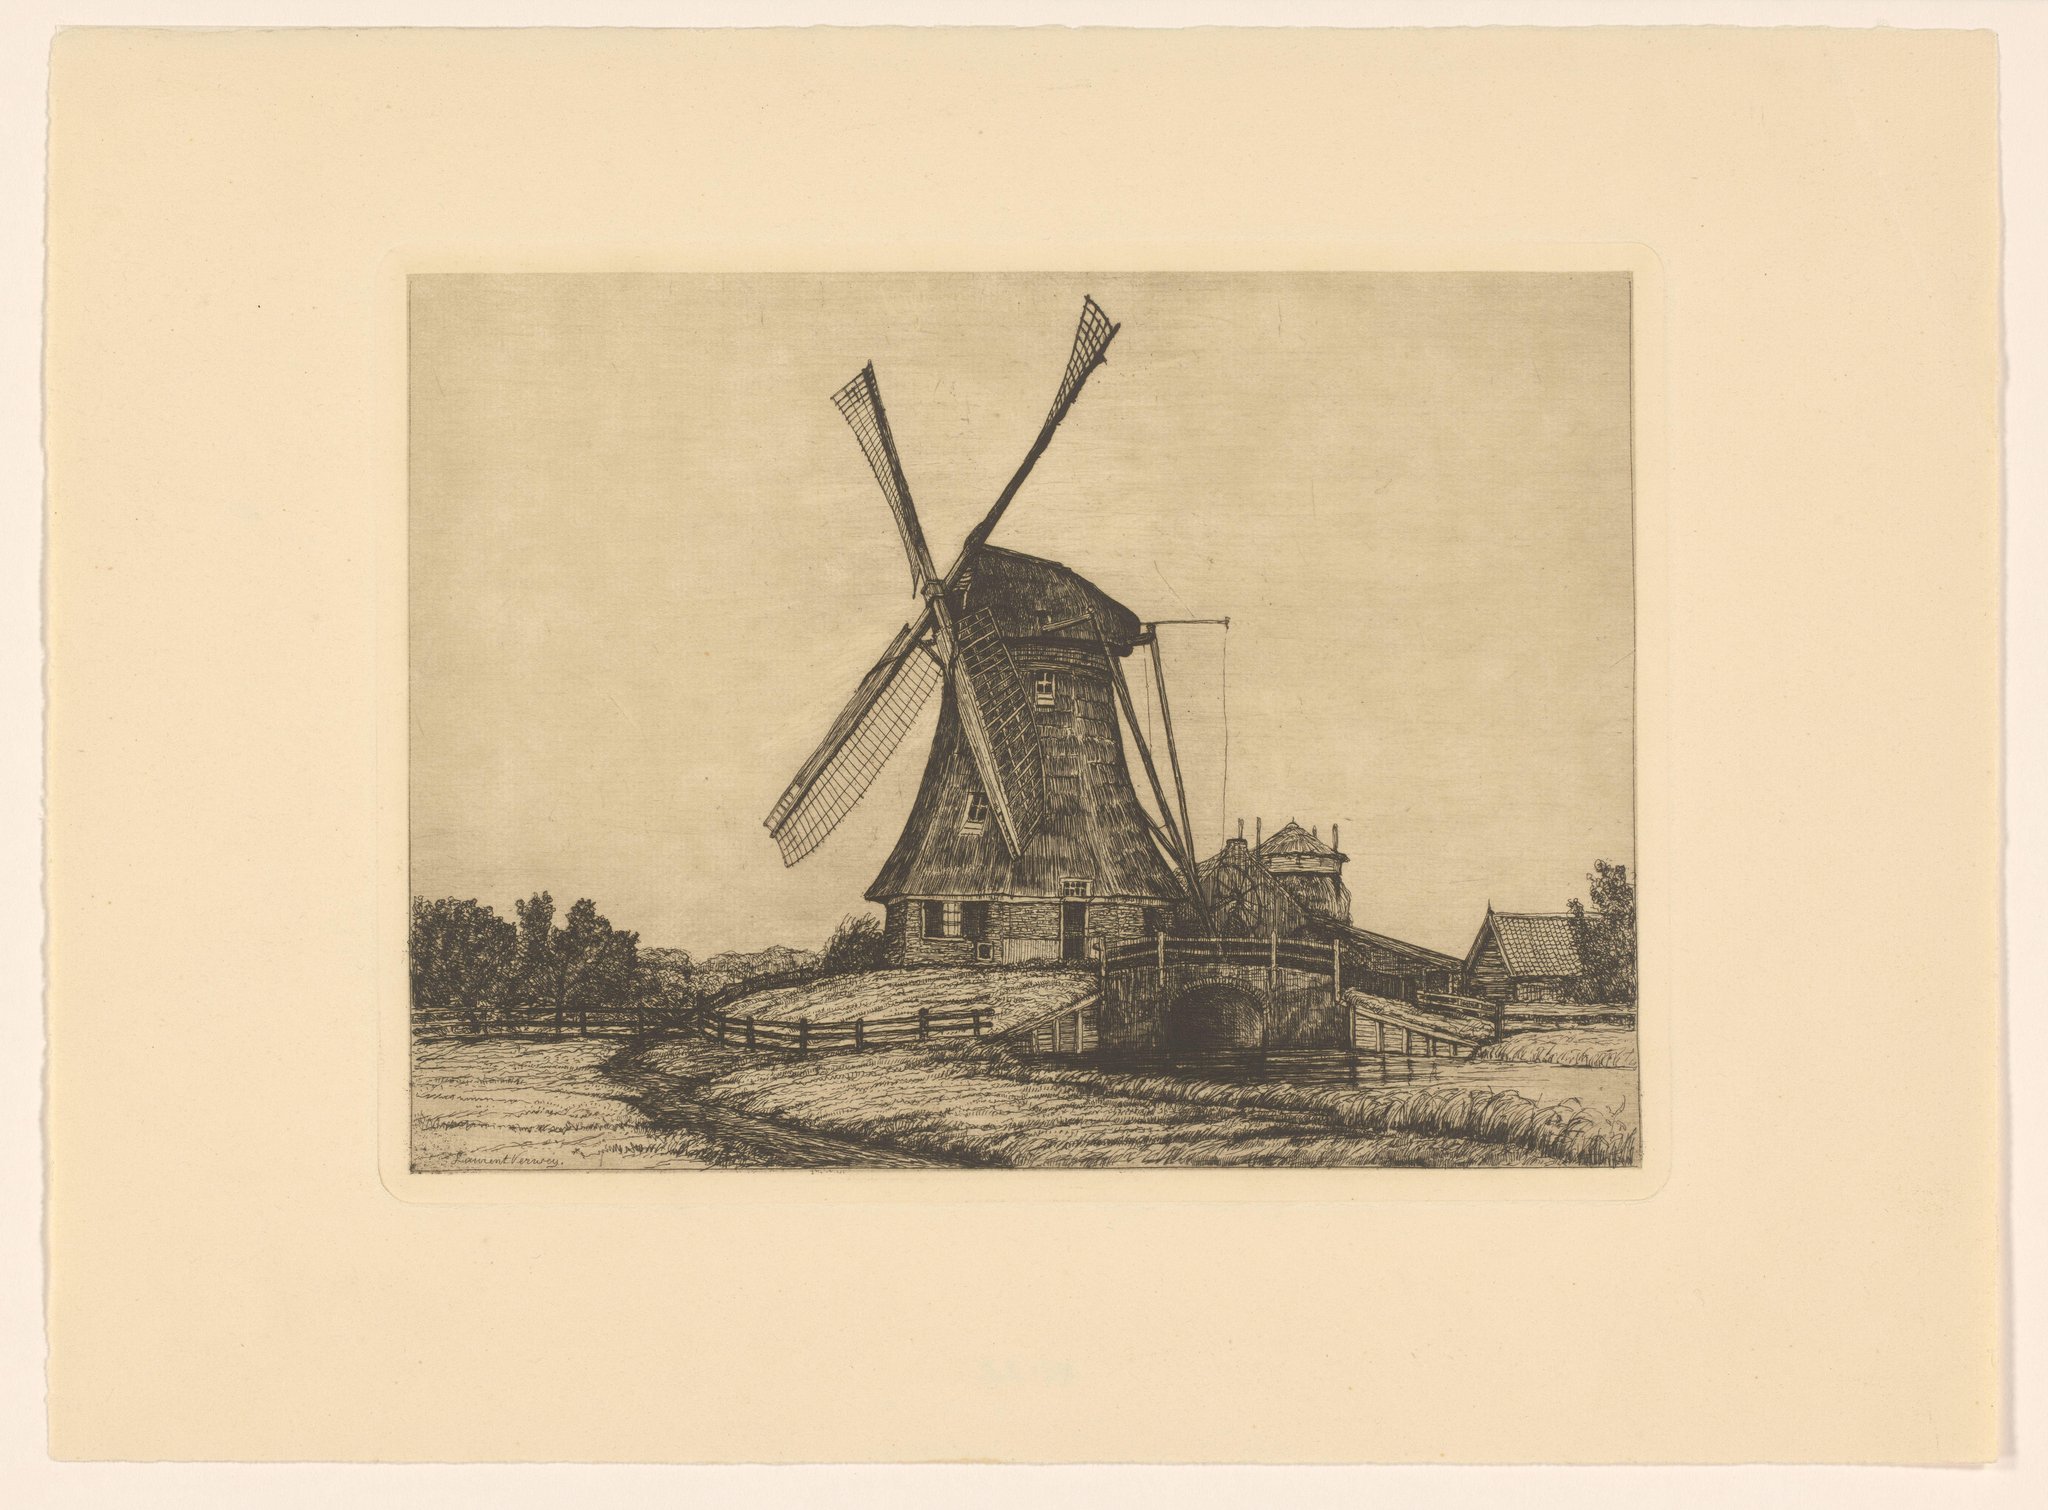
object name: print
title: Windmolen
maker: laurent verwey van udenhout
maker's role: print maker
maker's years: 1884-1913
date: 1894-1913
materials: paper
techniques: etching, intaglio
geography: netherlands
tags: windmill in landscape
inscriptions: collector's mark: Lugt 2228